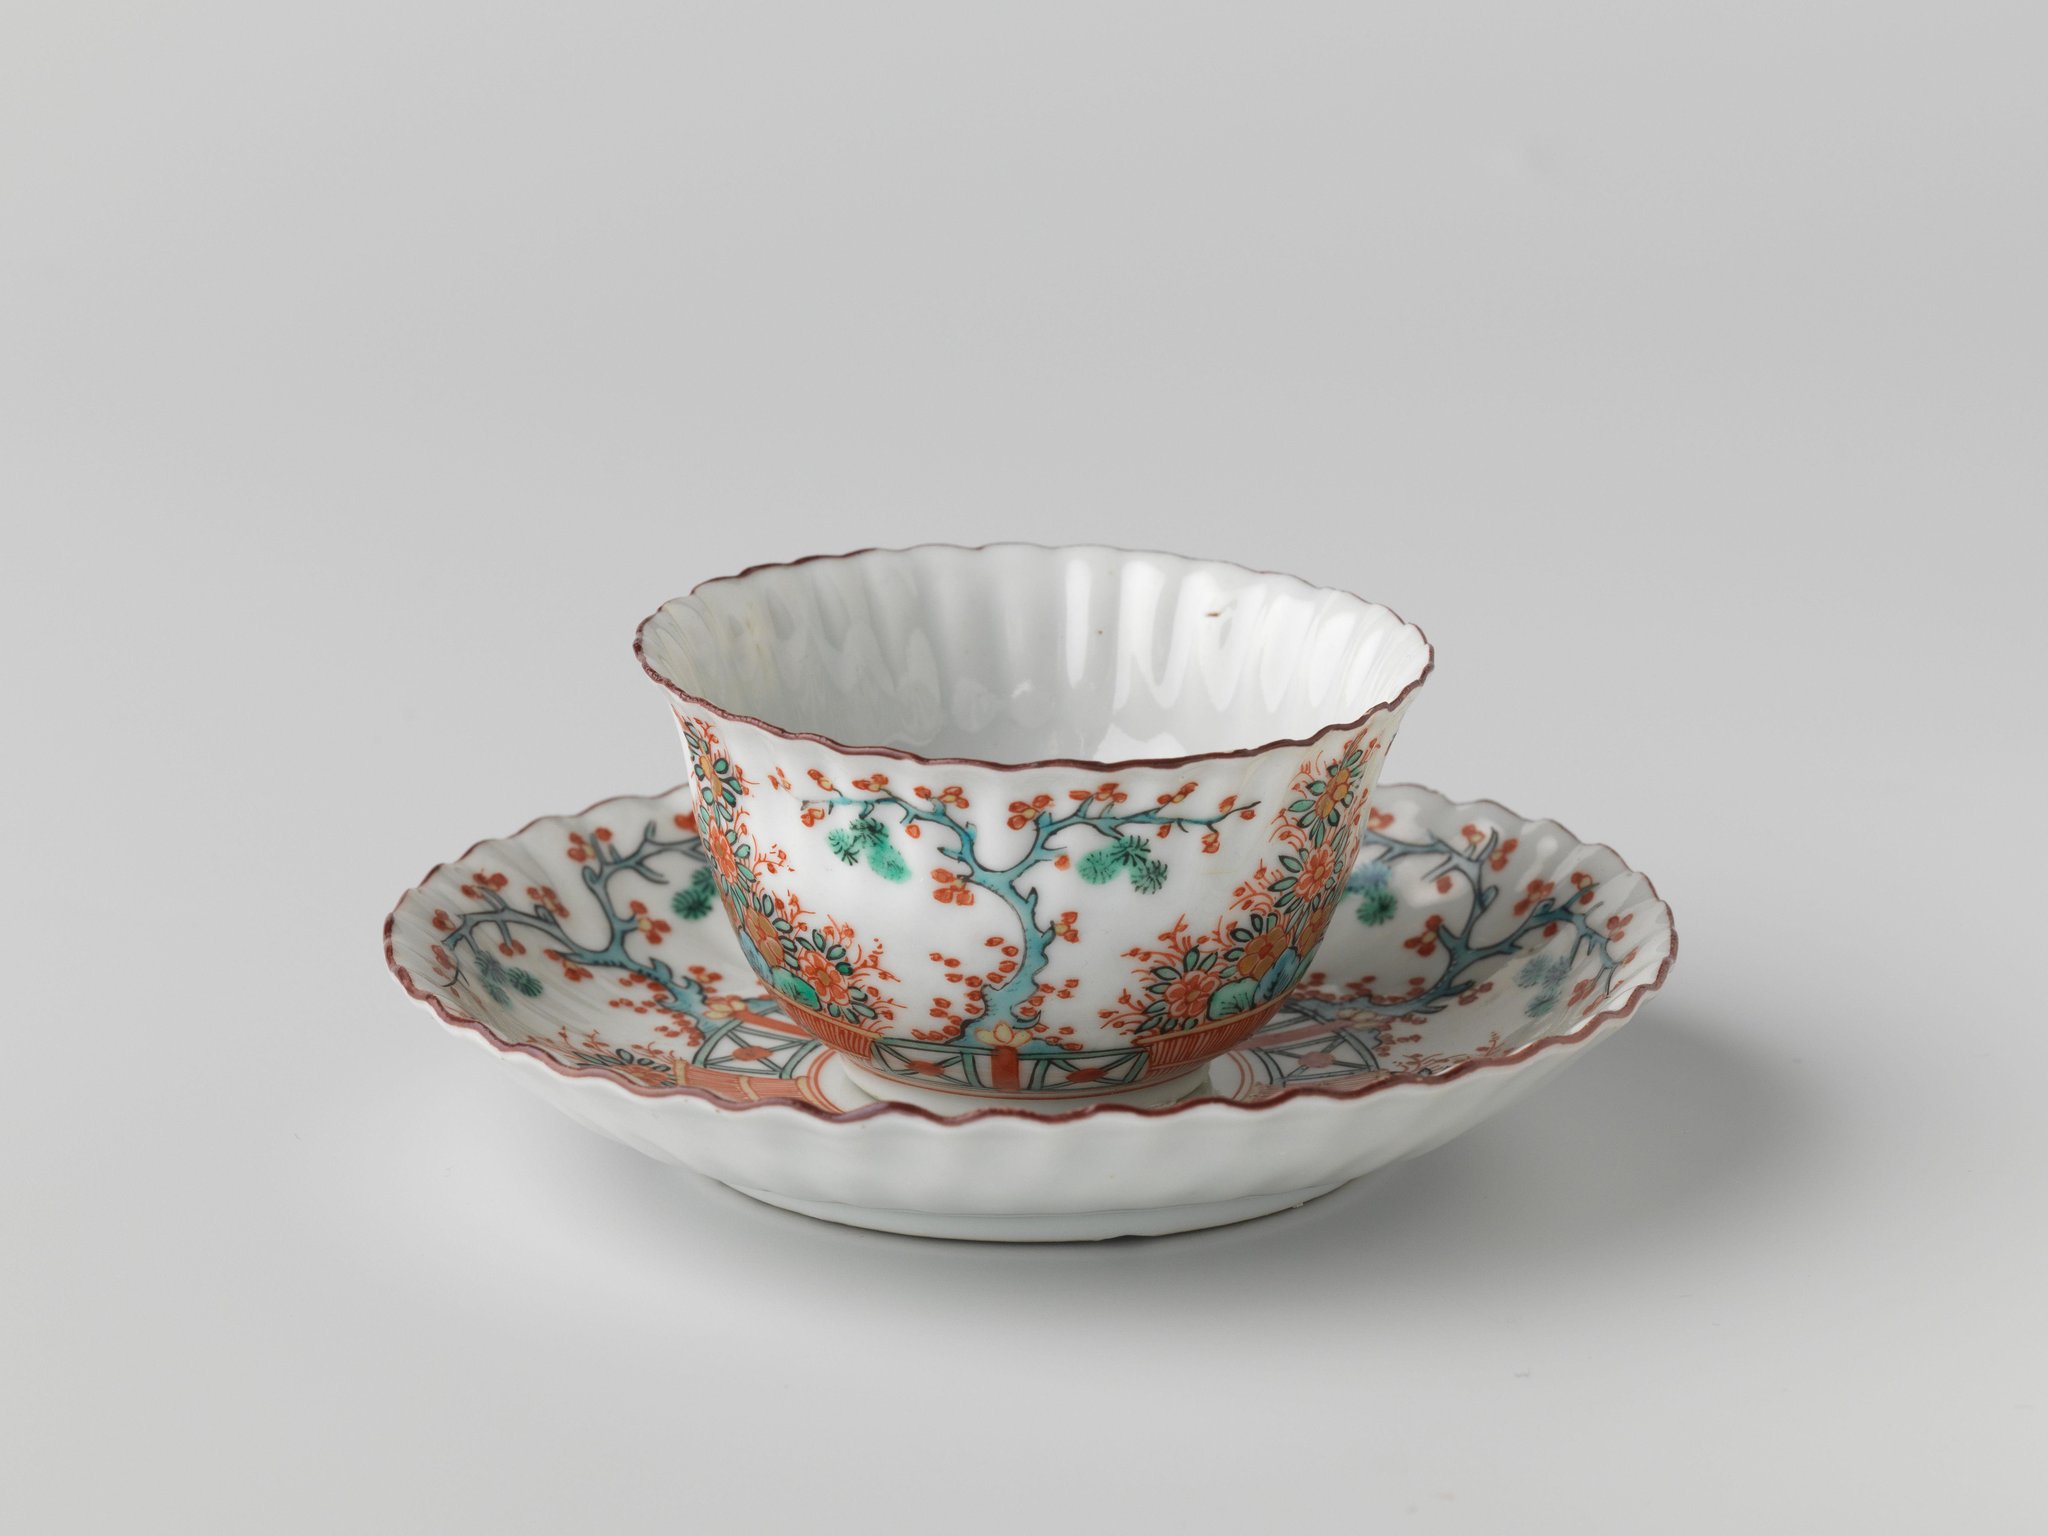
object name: kop en schotel, kop en schotel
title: Bell-shaped cup and saucer with fluted sides with a flower basket and a tree behind a fence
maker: Anonymous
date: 1700-1749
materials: glaze, gold, paint, porcelain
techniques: firing, gilding, turning, vitrification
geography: china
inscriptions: mark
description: Klokvormige kop en schotel van porselein met een geribde wand, beschilderd op het glazuur in blauw, rood, groen, zwart en goud. Op het plat van de schotel in het centrum een bloemrozet; daaromheen een medaillon waarop afwisselend drie bloemenmanden en driemaal een boom achter een hek. De kop met dezelfde decoratie. Gemerkt op de onderzijde met een imitatiemerk. In Europa gedecoreerd.